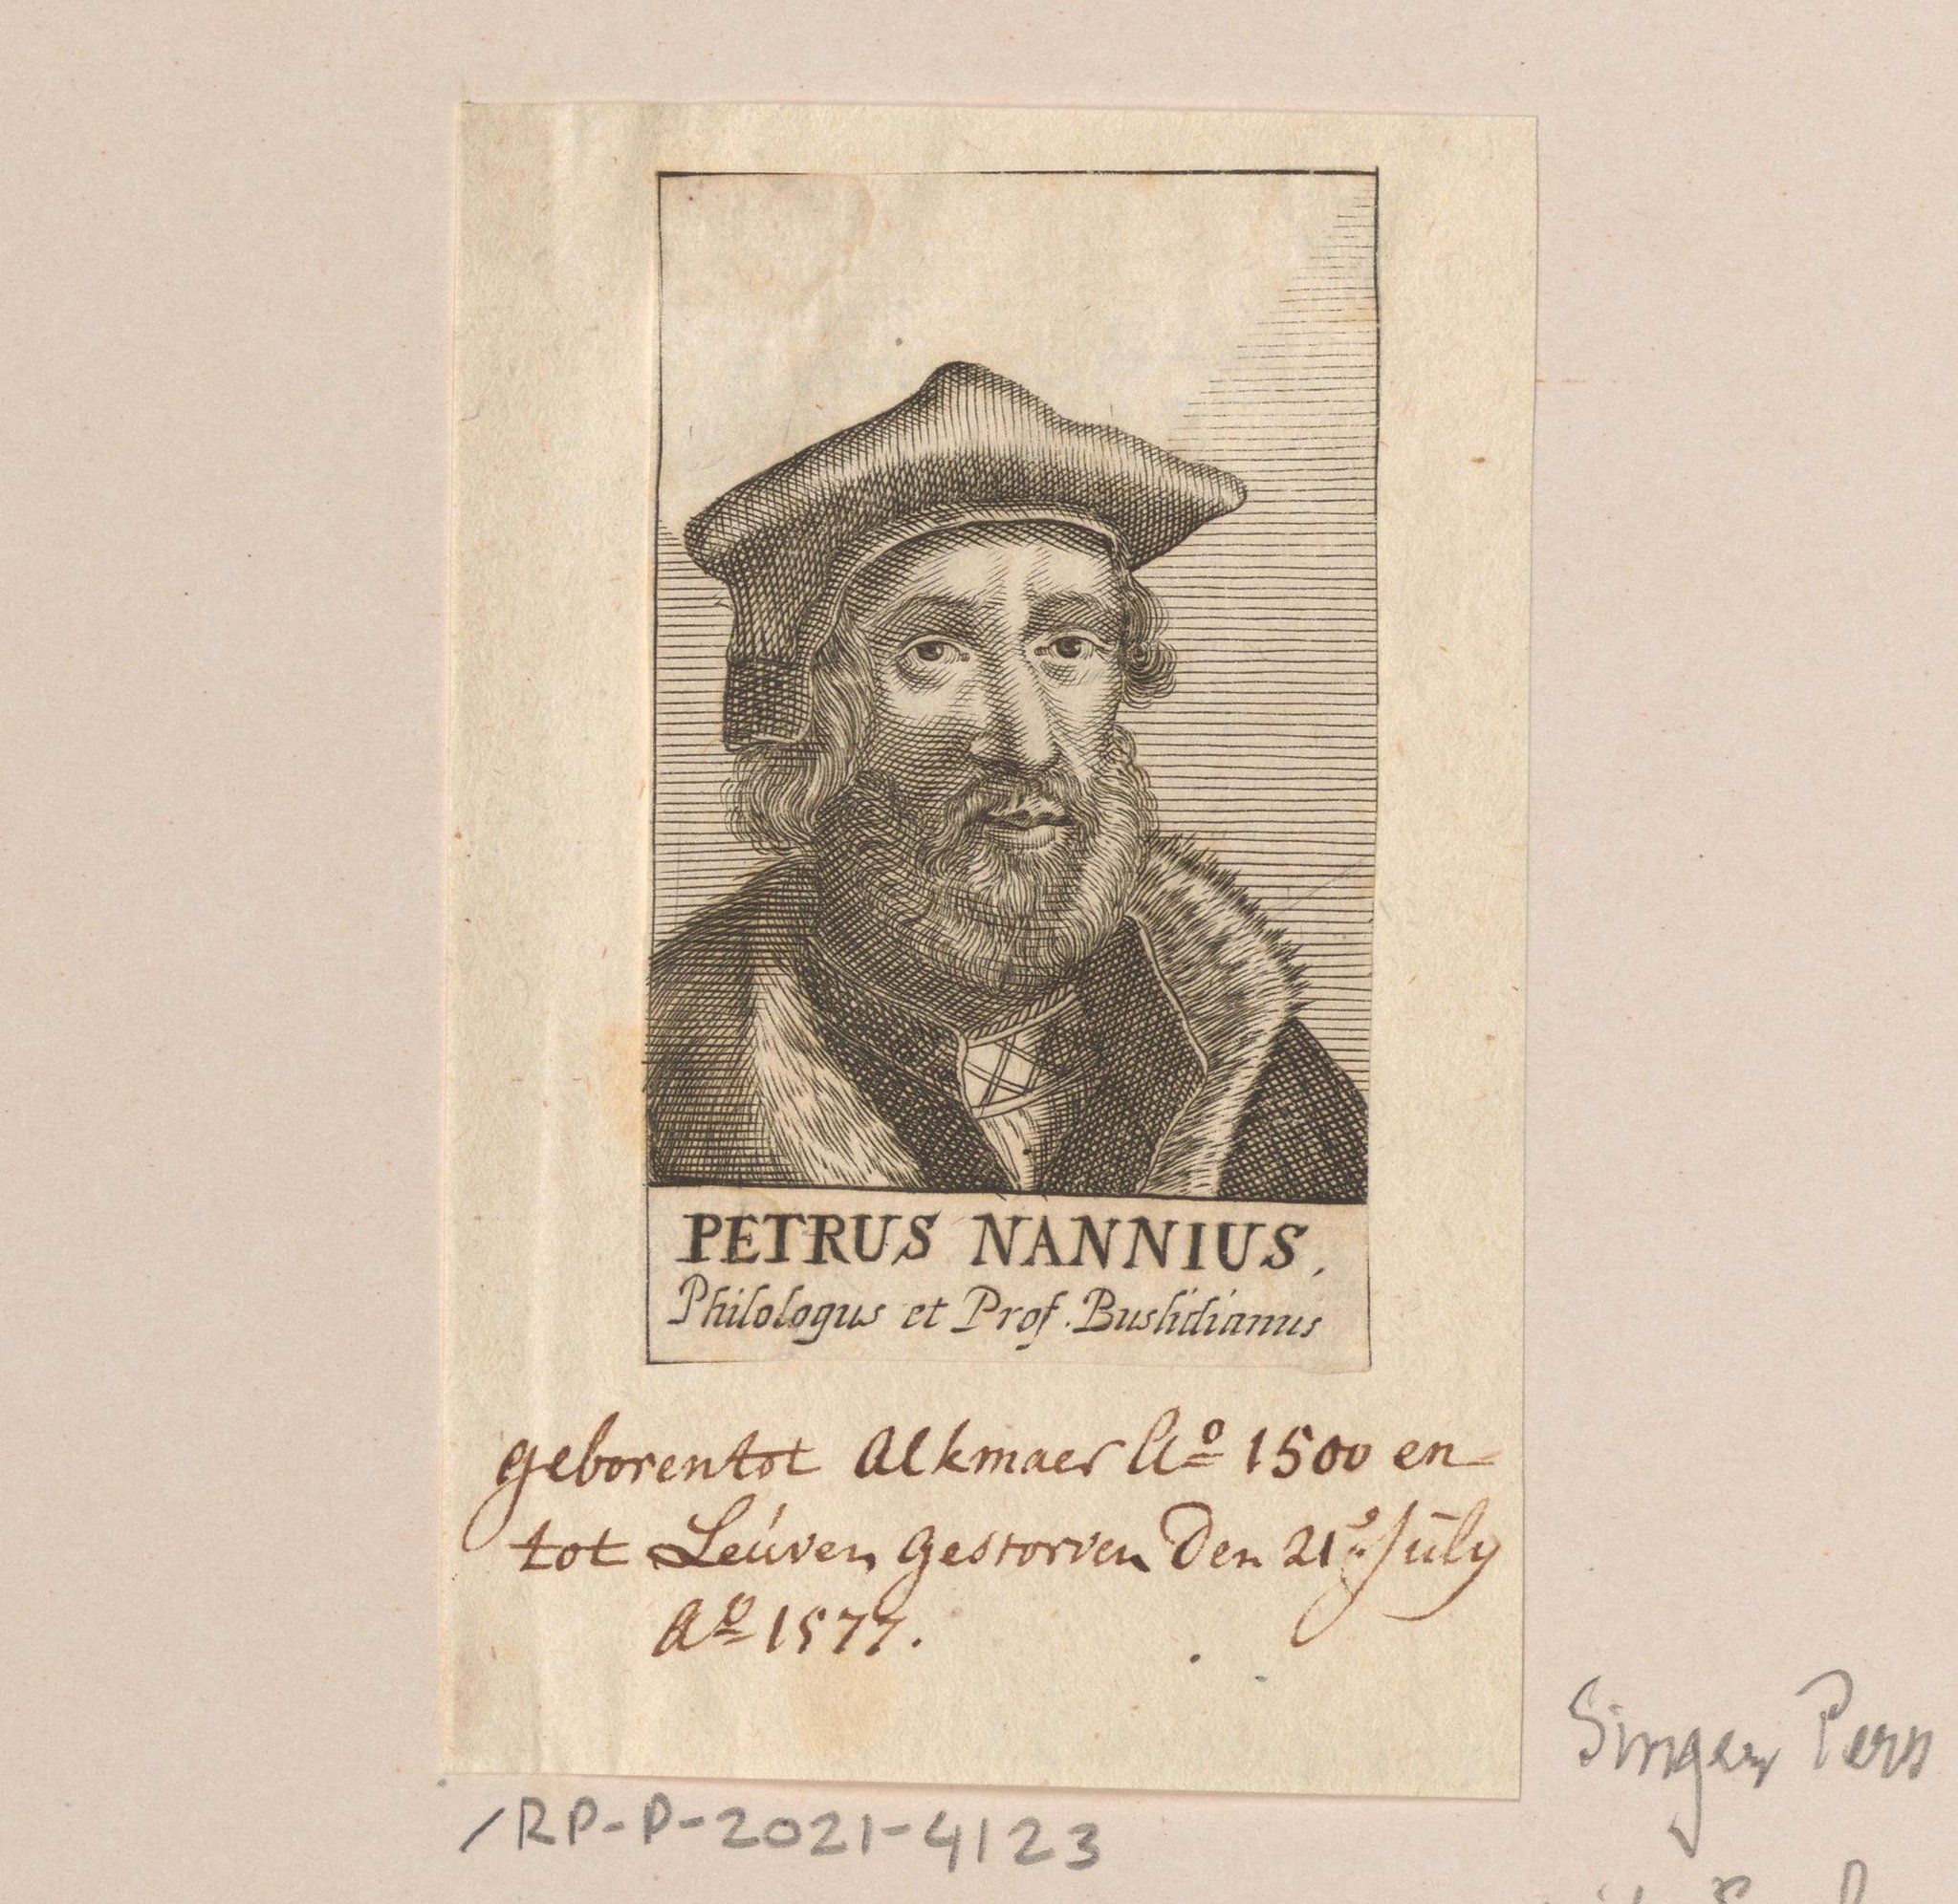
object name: print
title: Portret van Petrus Nannius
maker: Anonymous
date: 1688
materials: paper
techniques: engraving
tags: historical persons, physician, doctor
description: Prent maakt deel uit van een grotere prent die later is verknipt. Prent waarschijnlijk uit: Freher, Paul. Theatrum virorum eruditione clarorum. Neurenberg: Johann Hoffmann, 1688.